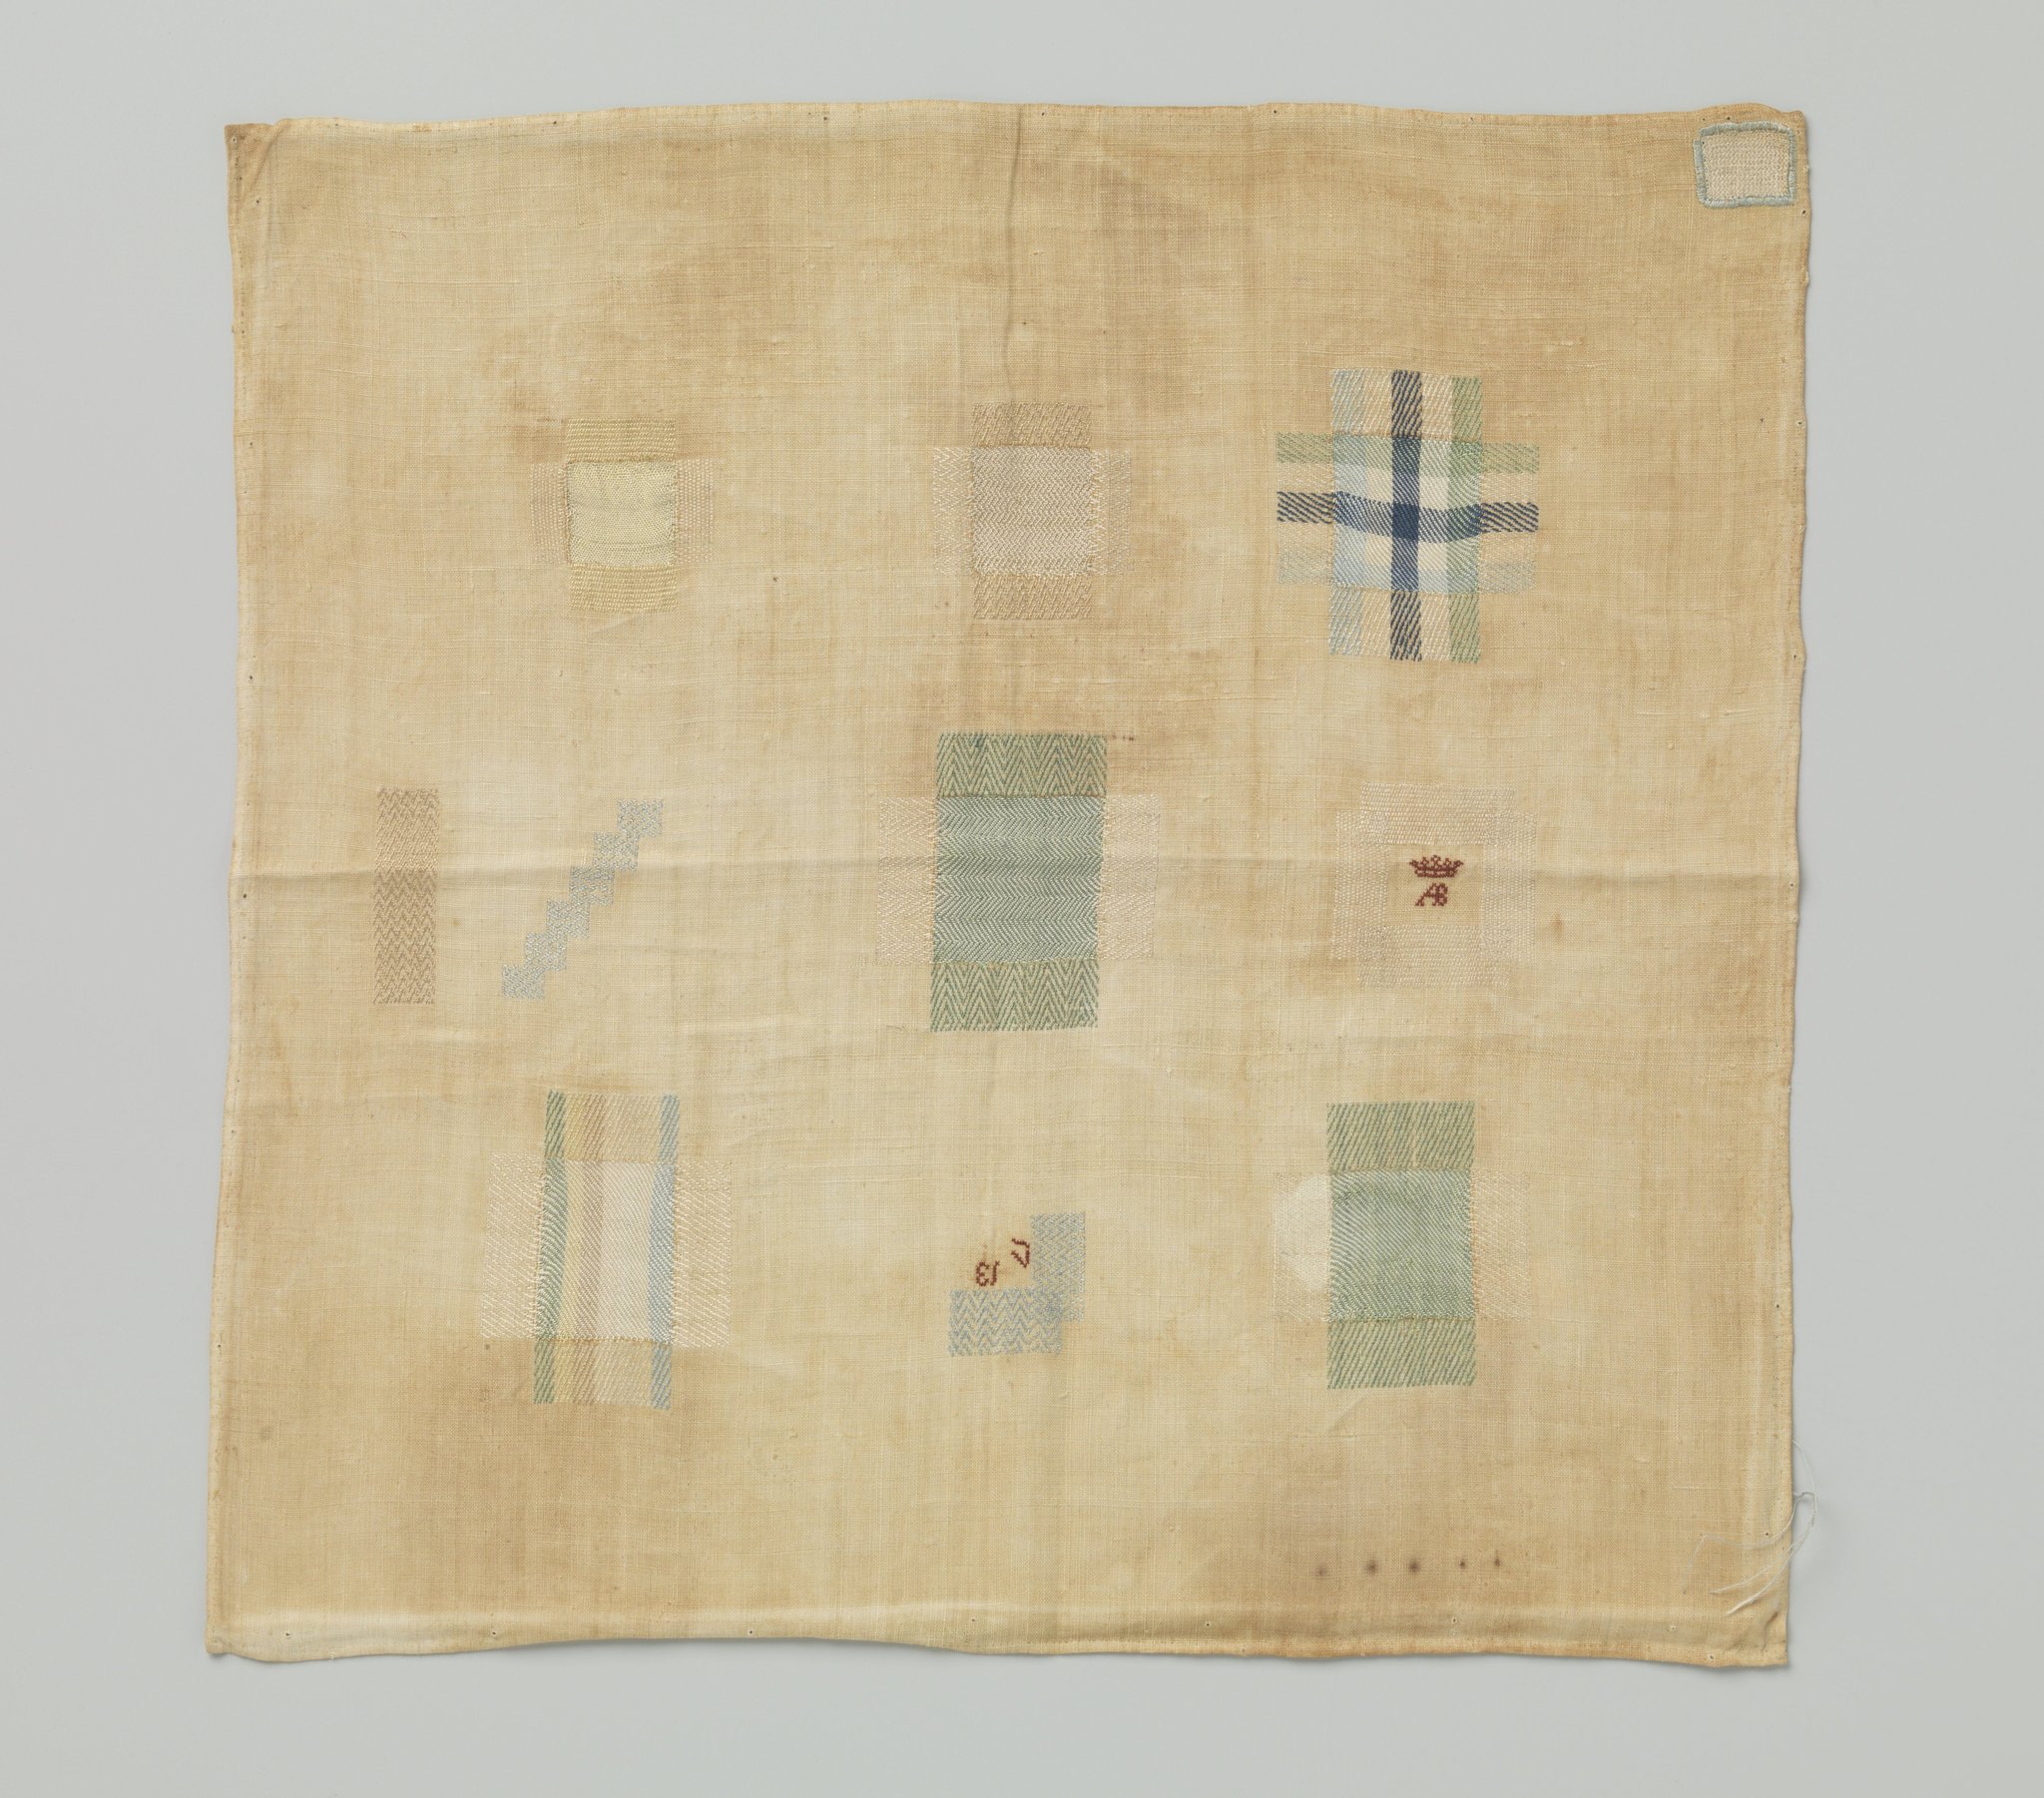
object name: stoplap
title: Stoplap van veelkleurige zijde op linnen.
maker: Anonymous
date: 1713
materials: linen, silk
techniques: embroidered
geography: netherlands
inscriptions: signature and date: ‘AB, 1713’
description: Stoplap van linnen gestopt met 11 stoppen in veelkleurige zijde. Gedateerd en gesigneerd: 1713, AB. Nederland, 1713.